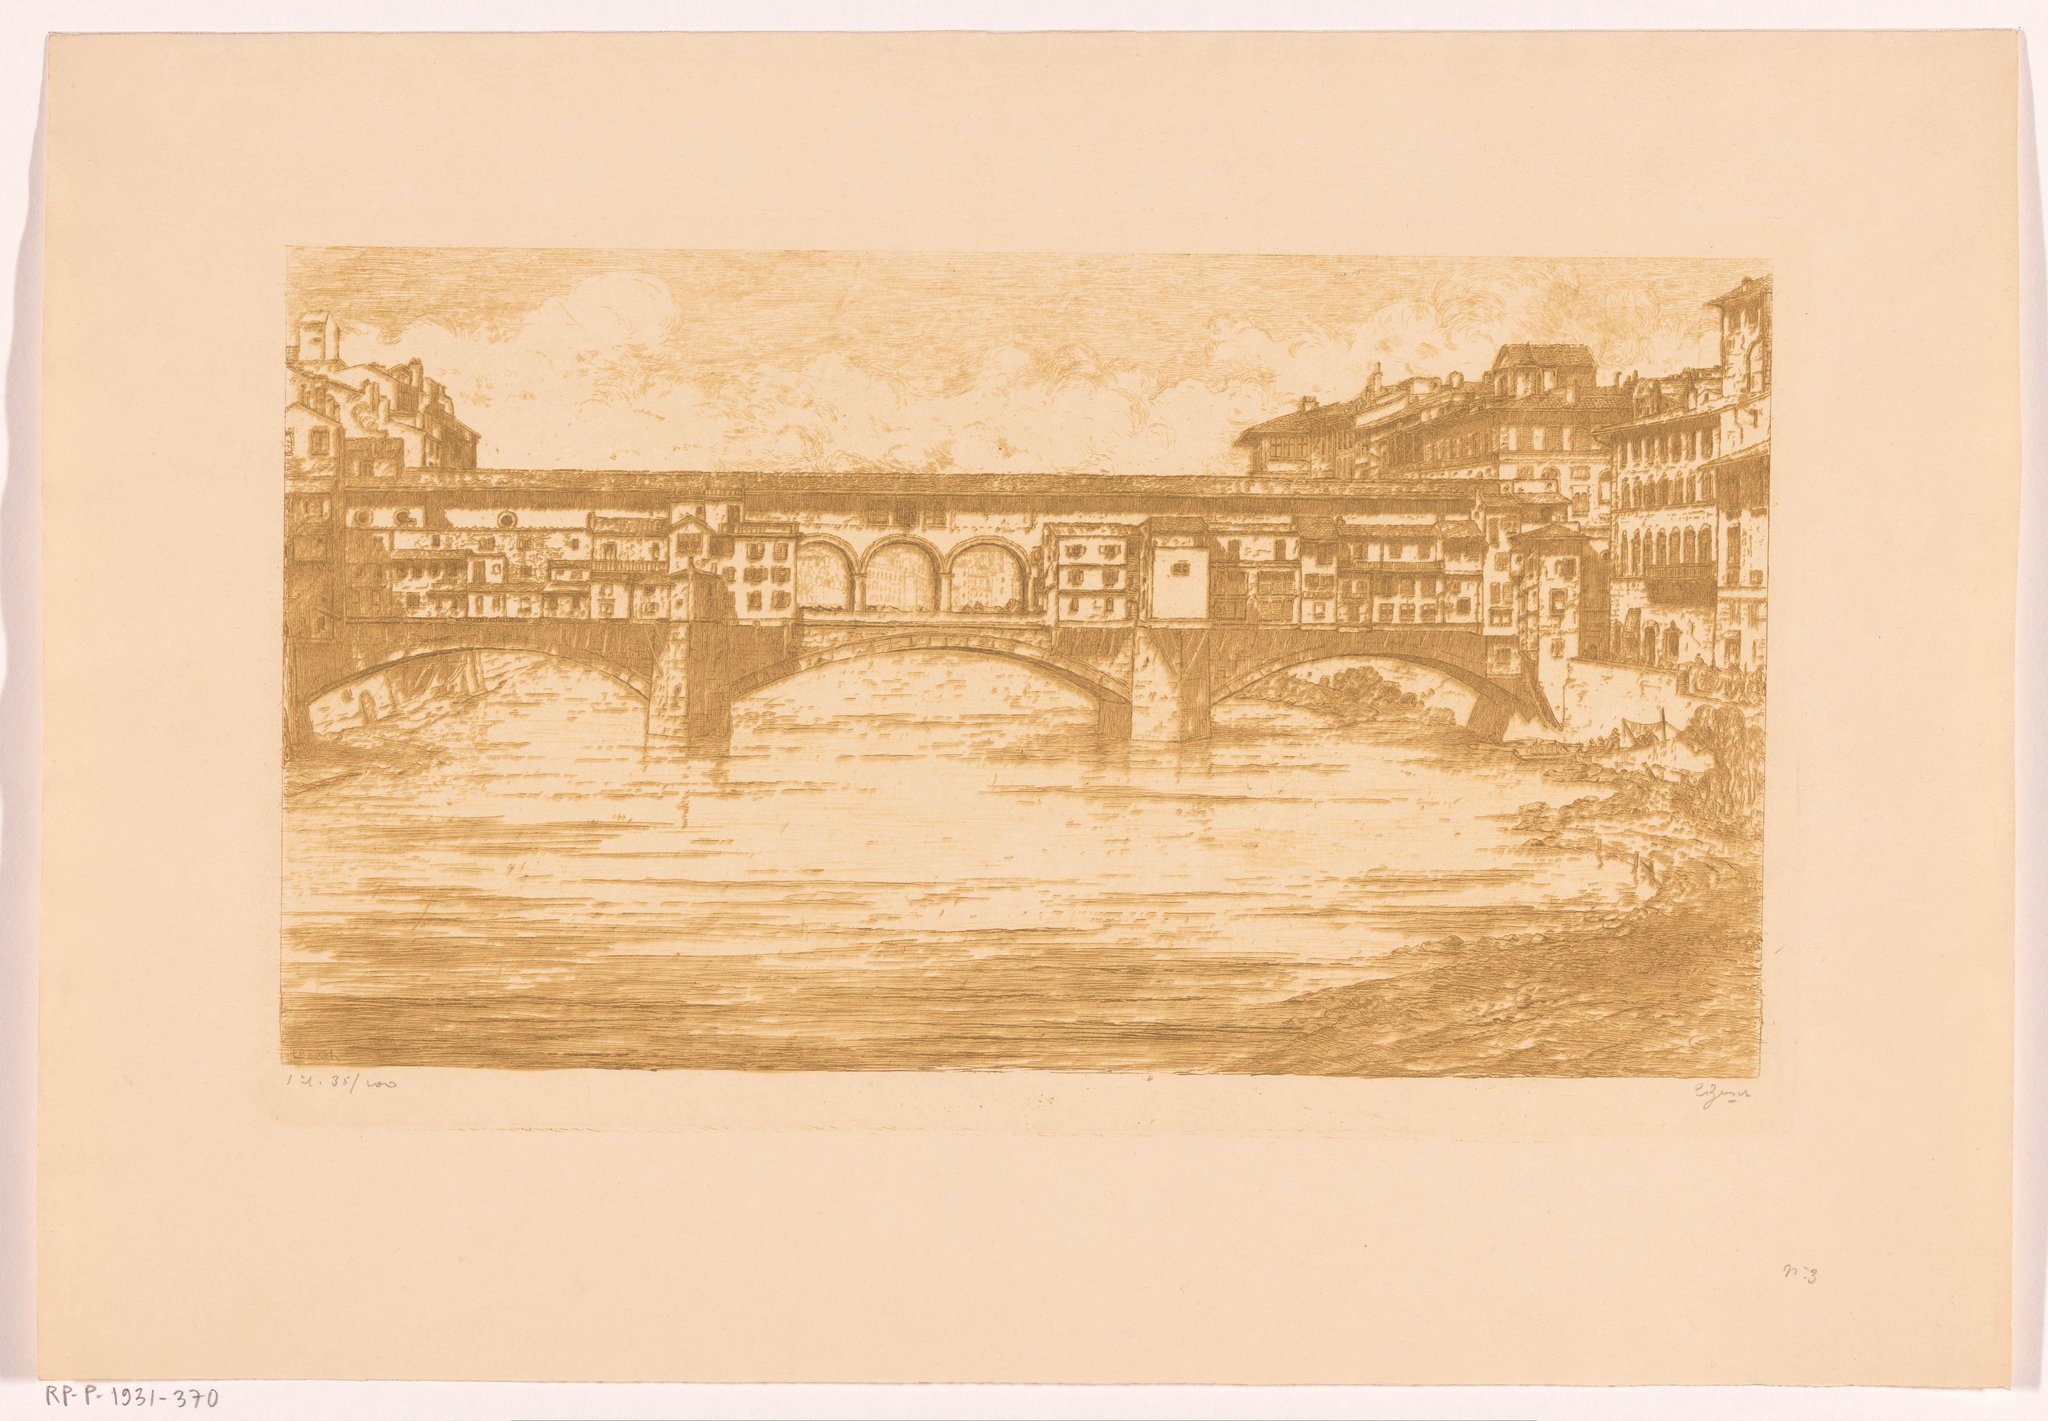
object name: print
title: Ponte Vecchio in Florence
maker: etienne bosch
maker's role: print maker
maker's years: 1863-1933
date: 1873-1931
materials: paper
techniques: etching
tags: bridge in city with structures, i.e. shops, houses, e.g. ponte vecchio in florence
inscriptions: number: ‘no. 3’, collector's mark: Lugt 2228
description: Zicht op de Ponte Vecchio over de rivier de Arno in Florence.